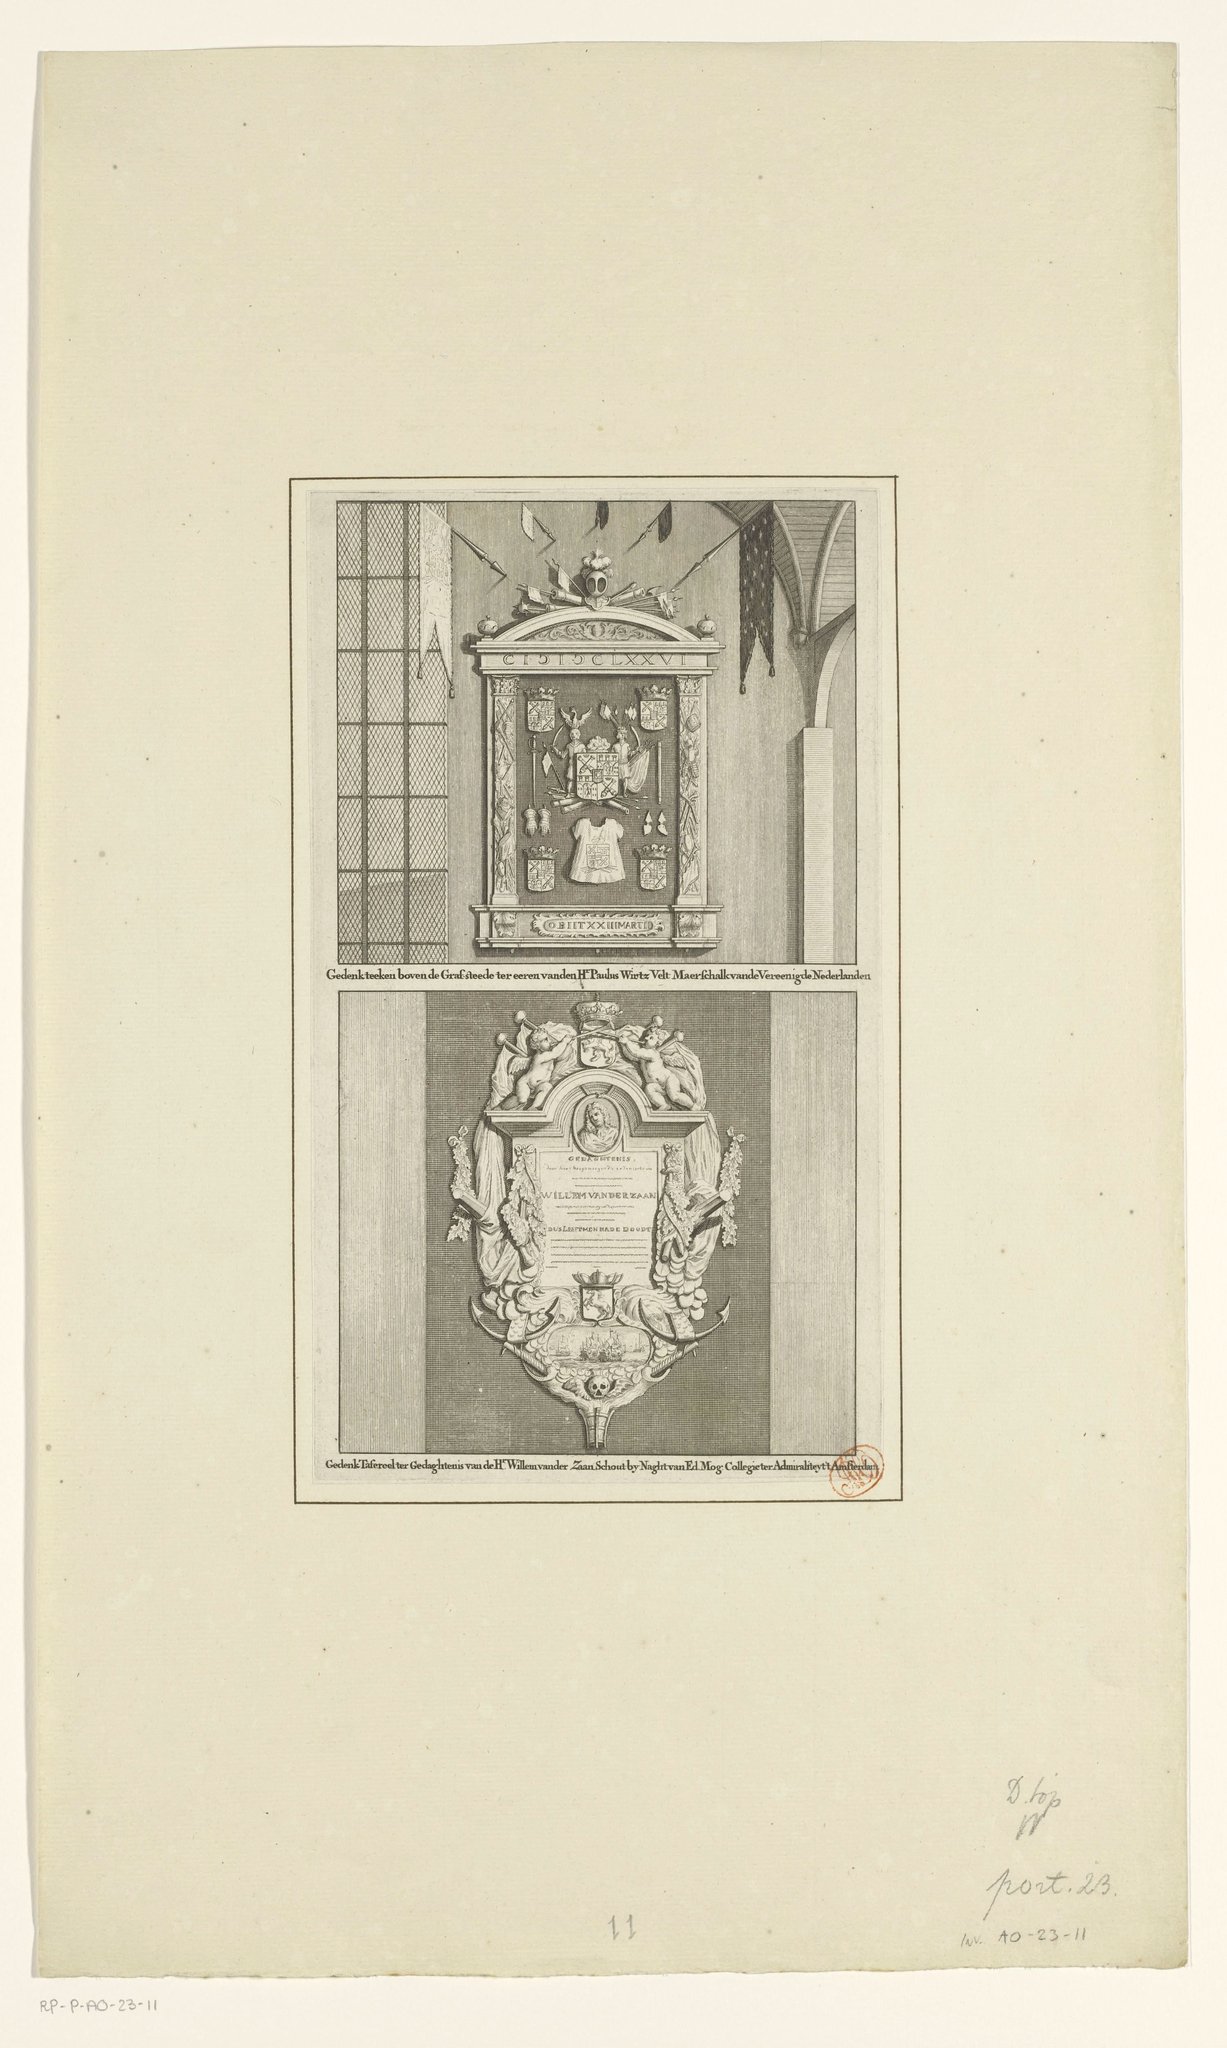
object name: book illustration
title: Grafmonumenten van veldmaarschalk Paulus Wirtz en schout-bij-nacht Willem van der Zaan in de Oude Kerk te Amsterdam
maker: Anonymous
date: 1693-1726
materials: paper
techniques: engraving, etching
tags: niche-tomb, wall-tomb, coat of arms (as symbol of the state, etc.) (+ nation; national), armorial bearing, heraldry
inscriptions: collector's mark: Lugt 195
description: Prent ook gebruikt in: Commelin, Caspar. Beschryvinge van Amsterdam, desselfs eerste oorspronk uyt den Huyse (…). 2 delen. Amsterdam: Abraham Wolfgang, Gillis Janssonius van Waesberge, Johannes Janssonius van Waesberge II, weduwe Dirk Boom I, Hendrick Boom en Rembertus Goethals, 1693. En in: Commelin, Caspar. Beschryvinge van Amsterdam, zynde een naukeurige verhandelinge van desselfs eerste oorspronk uyt (…). 2 delen. Amsterdam: weduwe Aart Dircksz Oossaan, 1694. En in: Commelin, Caspar. Beschryvinge van Amsterdam, zynde een naukeurige verhandelinge van desselfs eerste oorspronk uyt (…). 2 delen. 2e druk. Amsterdam: Andries van Damme, Johannes Ratelband, weduwe A. van Aaltwyk en Hermanus Uytwerf, 1726. Deze prent is ook ingebonden in enkele exemplaren van: Wagenaar, Jan. Amsterdam, in zyne opkomst, aanwas, geschiedenissen (…). 3 delen [folio-uitgave]. Amsterdam: Isaak Tirion en Yntema & Tieboel, 1760-1767, dl. 2 (Isaak Tirion, 1765). Komt echter niet voor in de lijst met in te binden prenten van deze uitgave (te vinden in dl. 3) - en is er dus ook niet voor bedoeld.